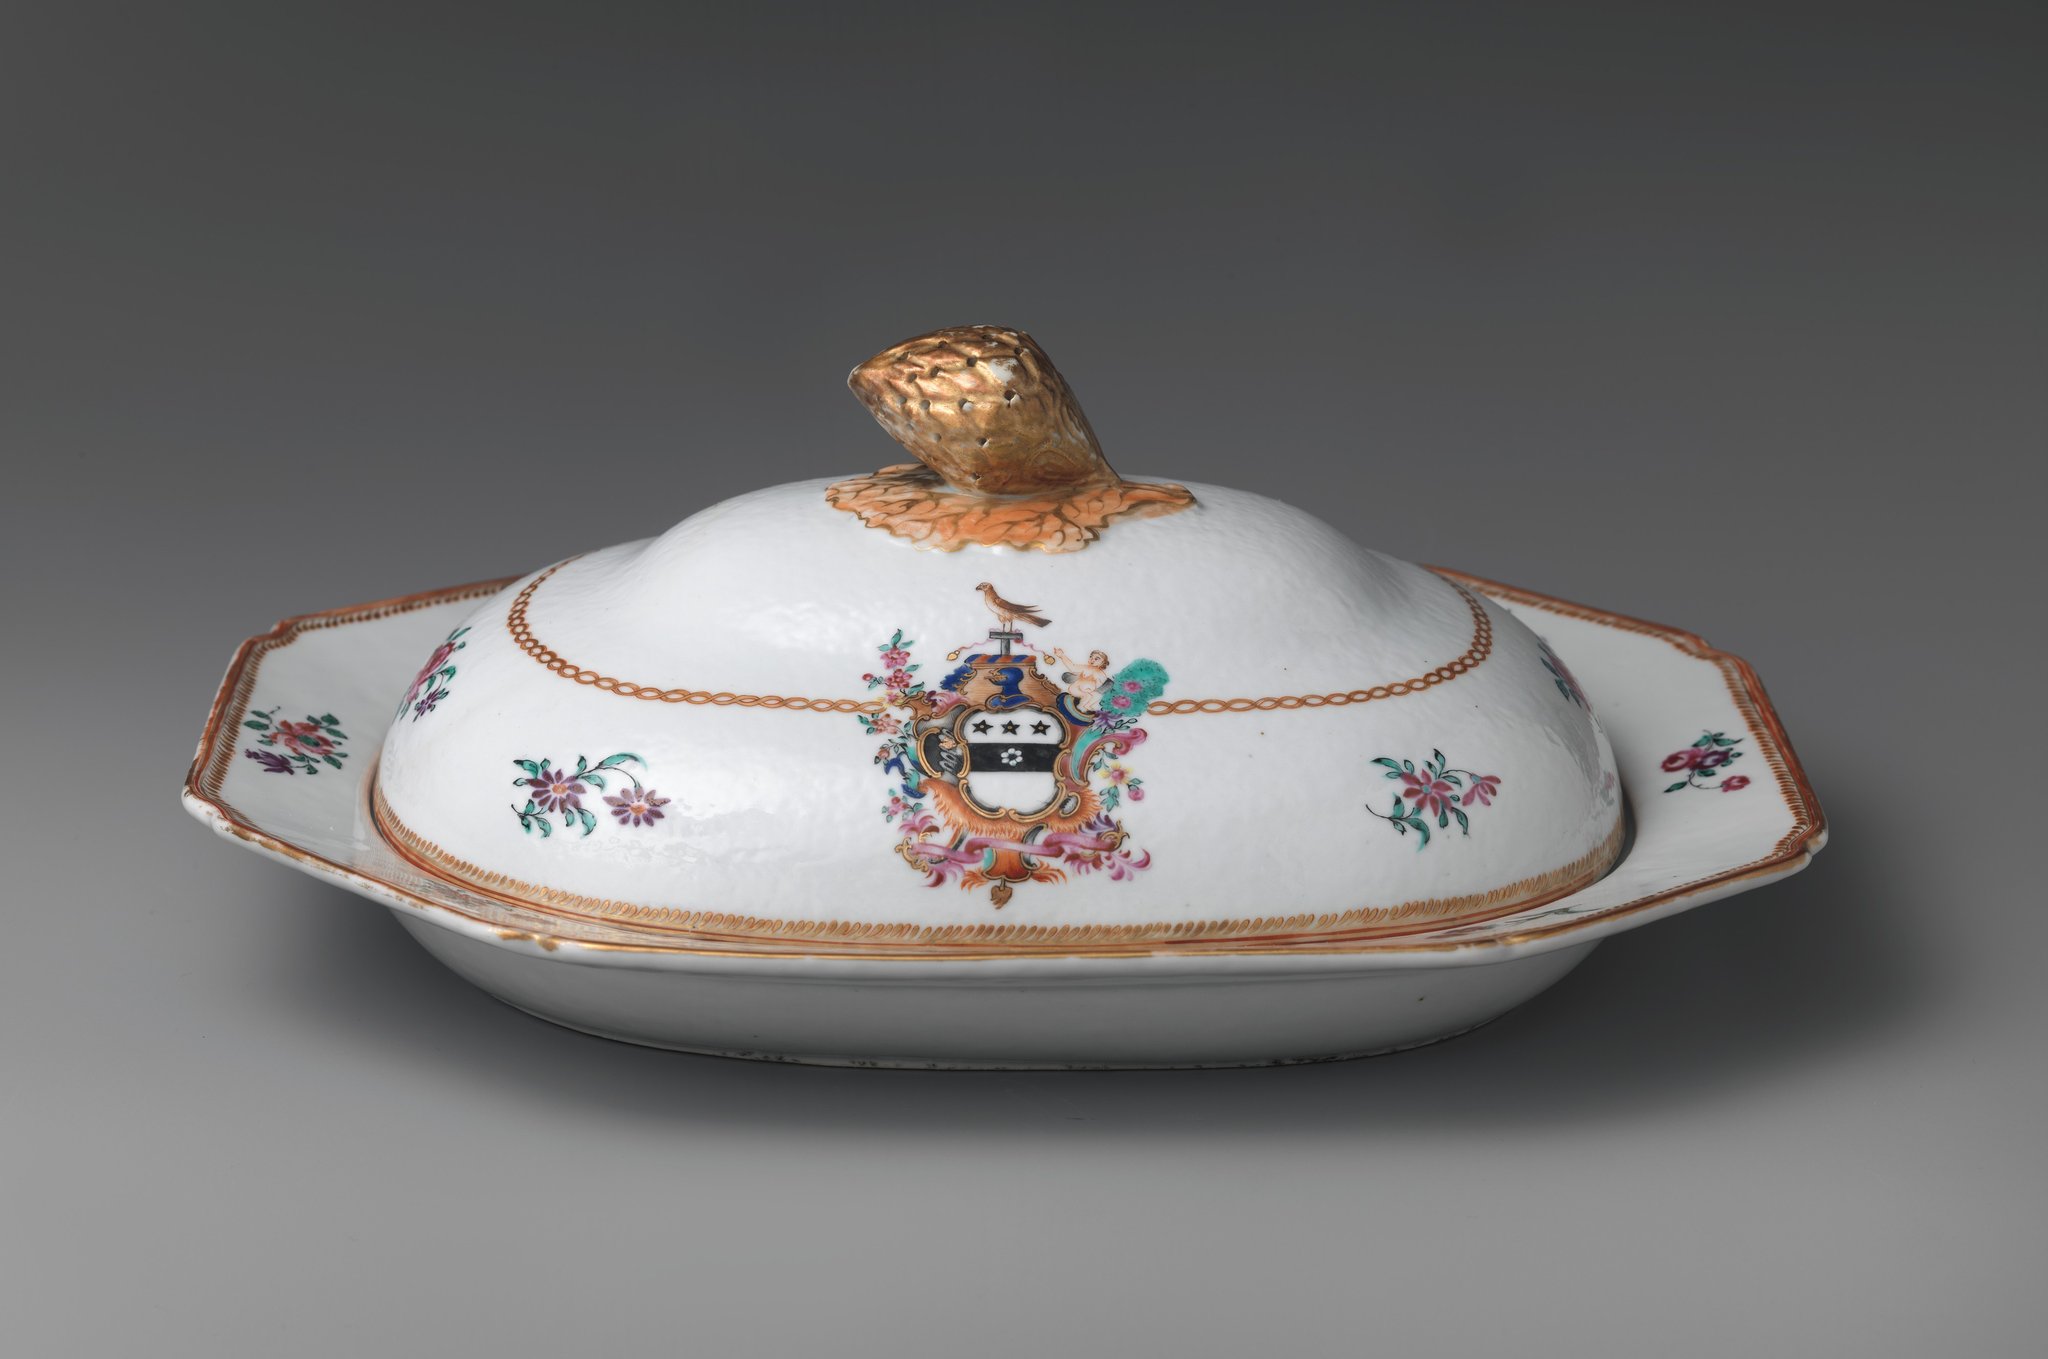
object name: platter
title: Covered Platter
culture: chinese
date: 1785-1790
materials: porcelain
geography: china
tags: birds,flowers,coat of arms